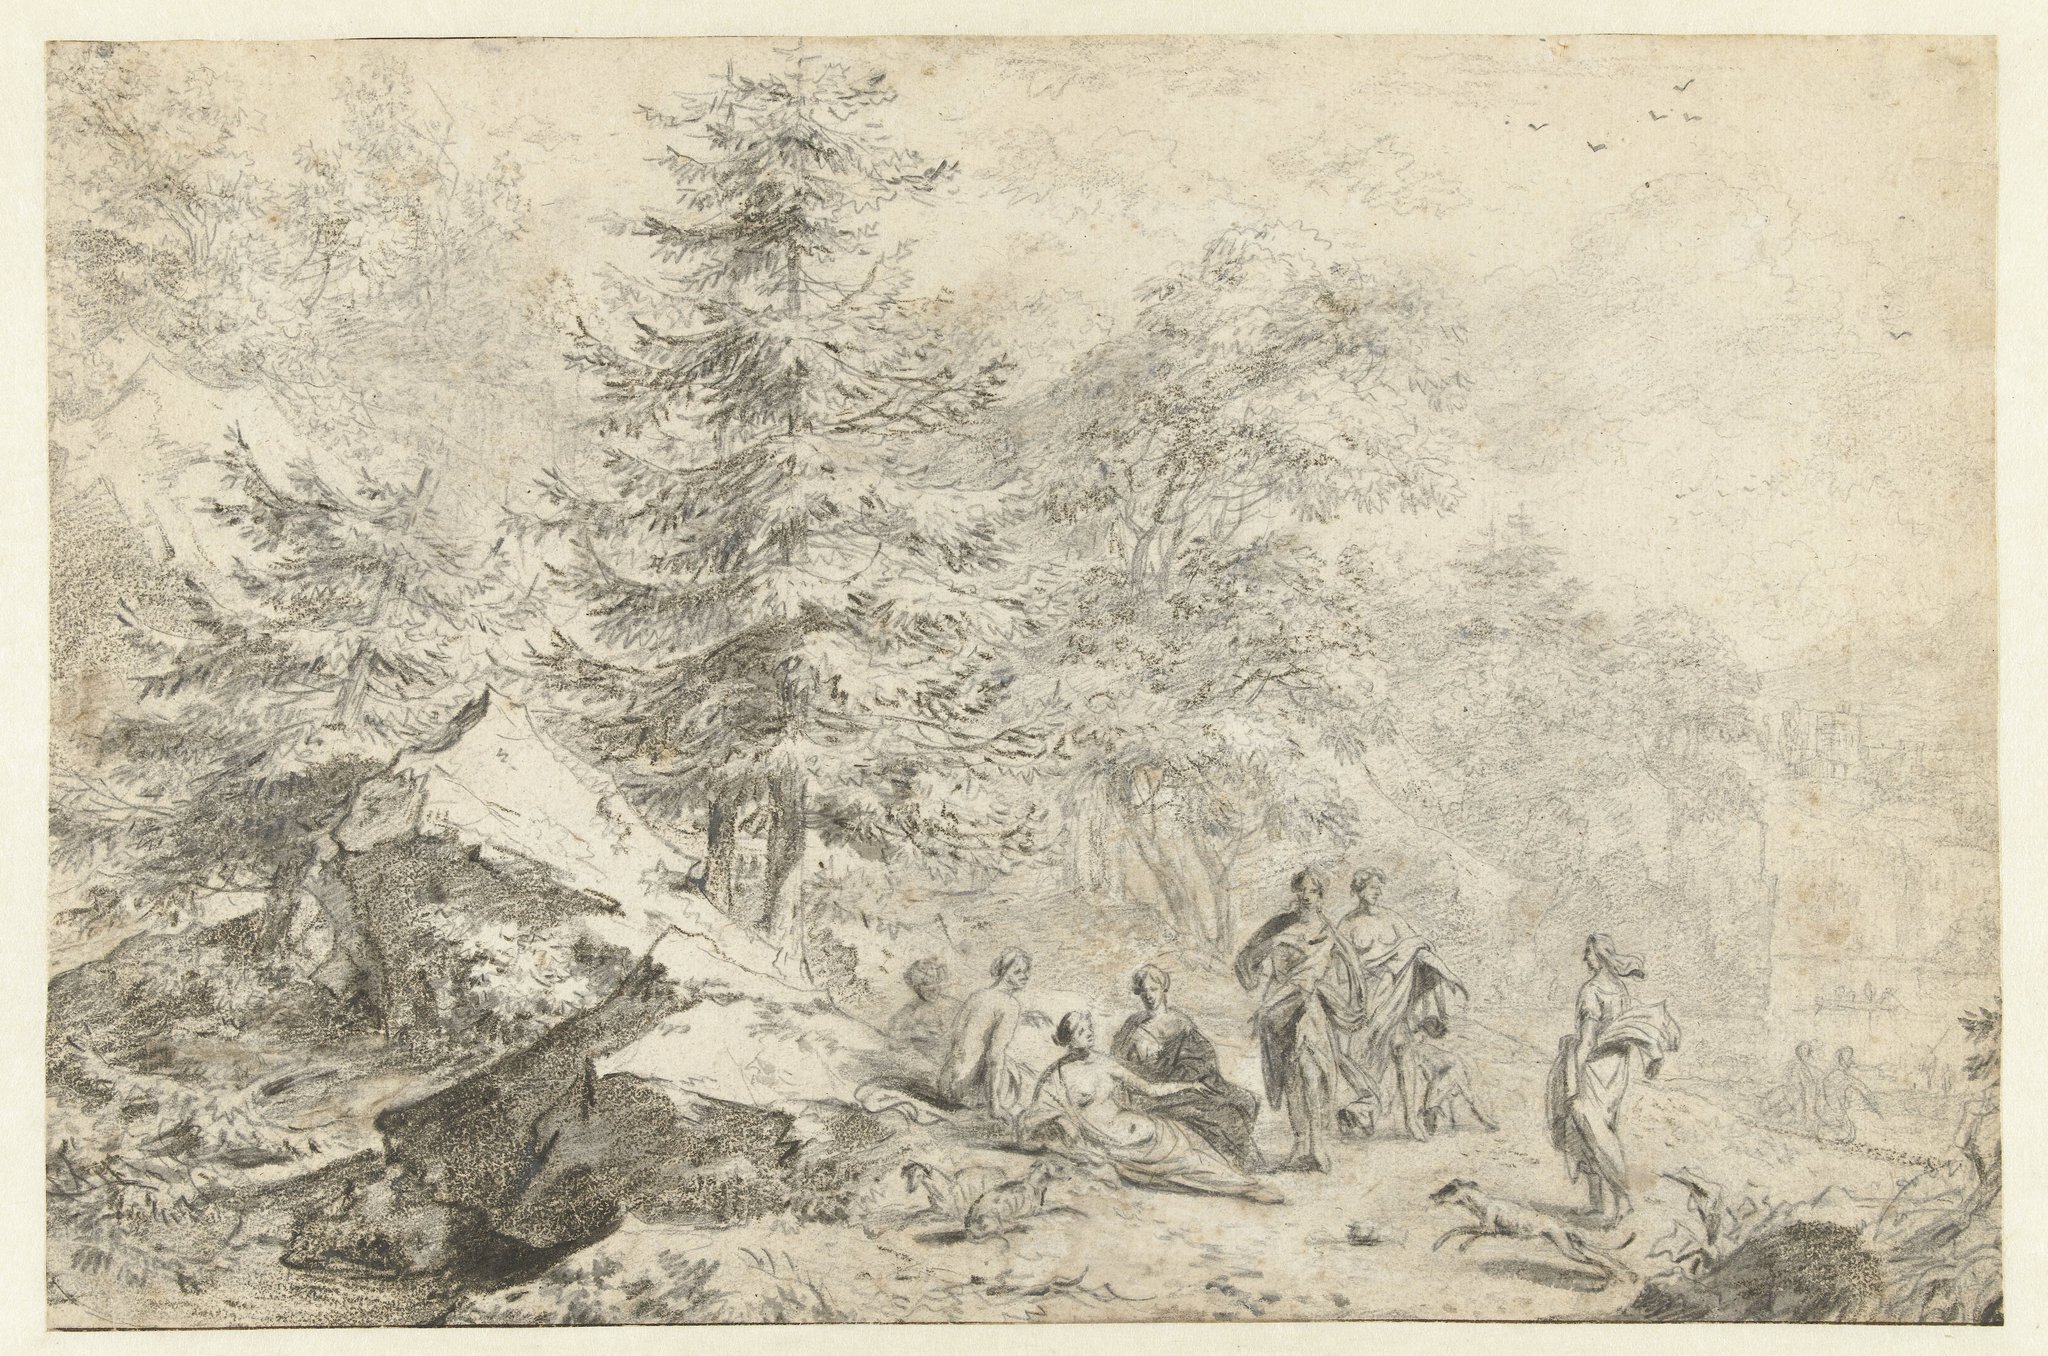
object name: drawing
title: Diana en haar nimfen aan de oever van een meer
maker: nicolaes pietersz berchem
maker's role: draughtsman, print maker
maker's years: 1620-1683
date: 1660-1665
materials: chalk, charcoal, paper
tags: forest, wood, diana bathing with her nymphs